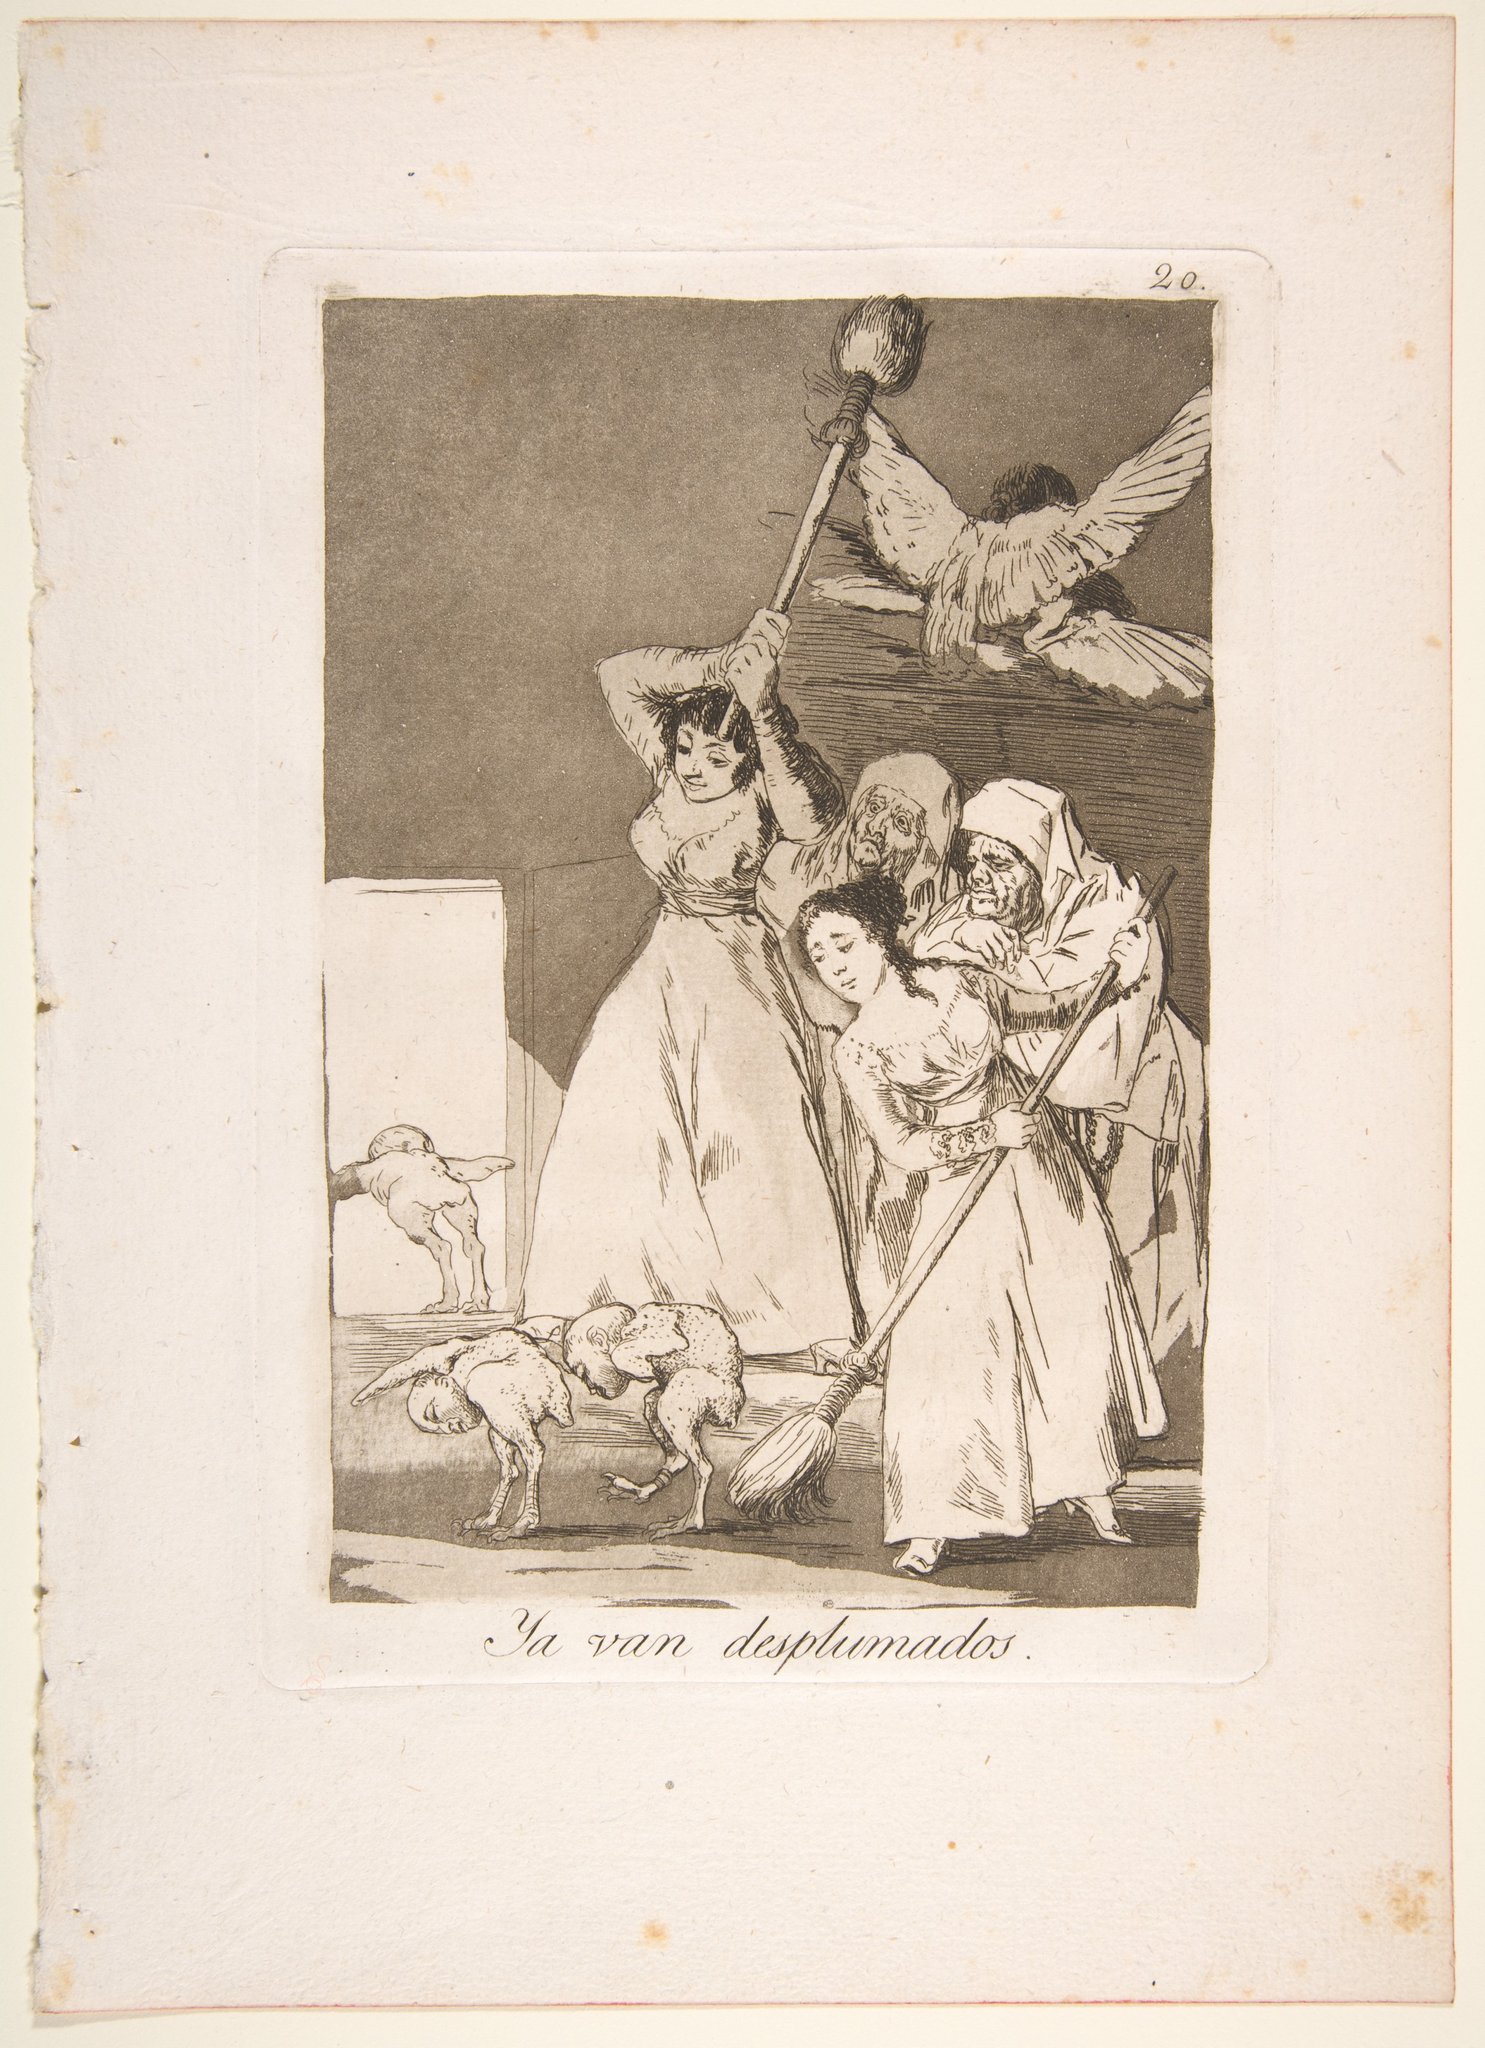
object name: print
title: Plate 20 from "Los Caprichos": There they go plucked (i.e. fleeced) (Ya van desplumados)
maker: goya (francisco de goya y lucientes)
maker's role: artist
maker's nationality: spanish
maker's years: 1746-1828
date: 1799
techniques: aquatint, burnishing, drypoint, etching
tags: satire,women